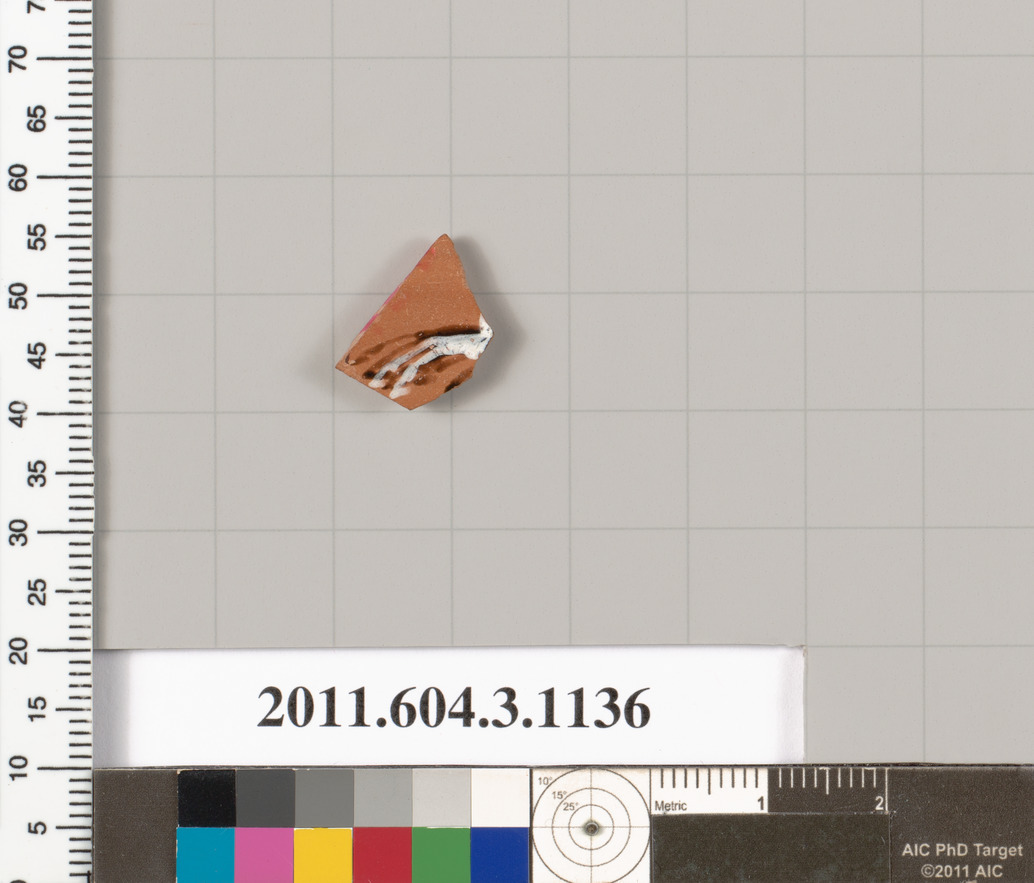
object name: mastoid or kyathos fragment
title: Terracotta fragment of a mastoid (drinking cup with narrow base) or a kyathos (cup-shaped ladle)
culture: greek, attic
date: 534-468 BCE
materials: terracotta